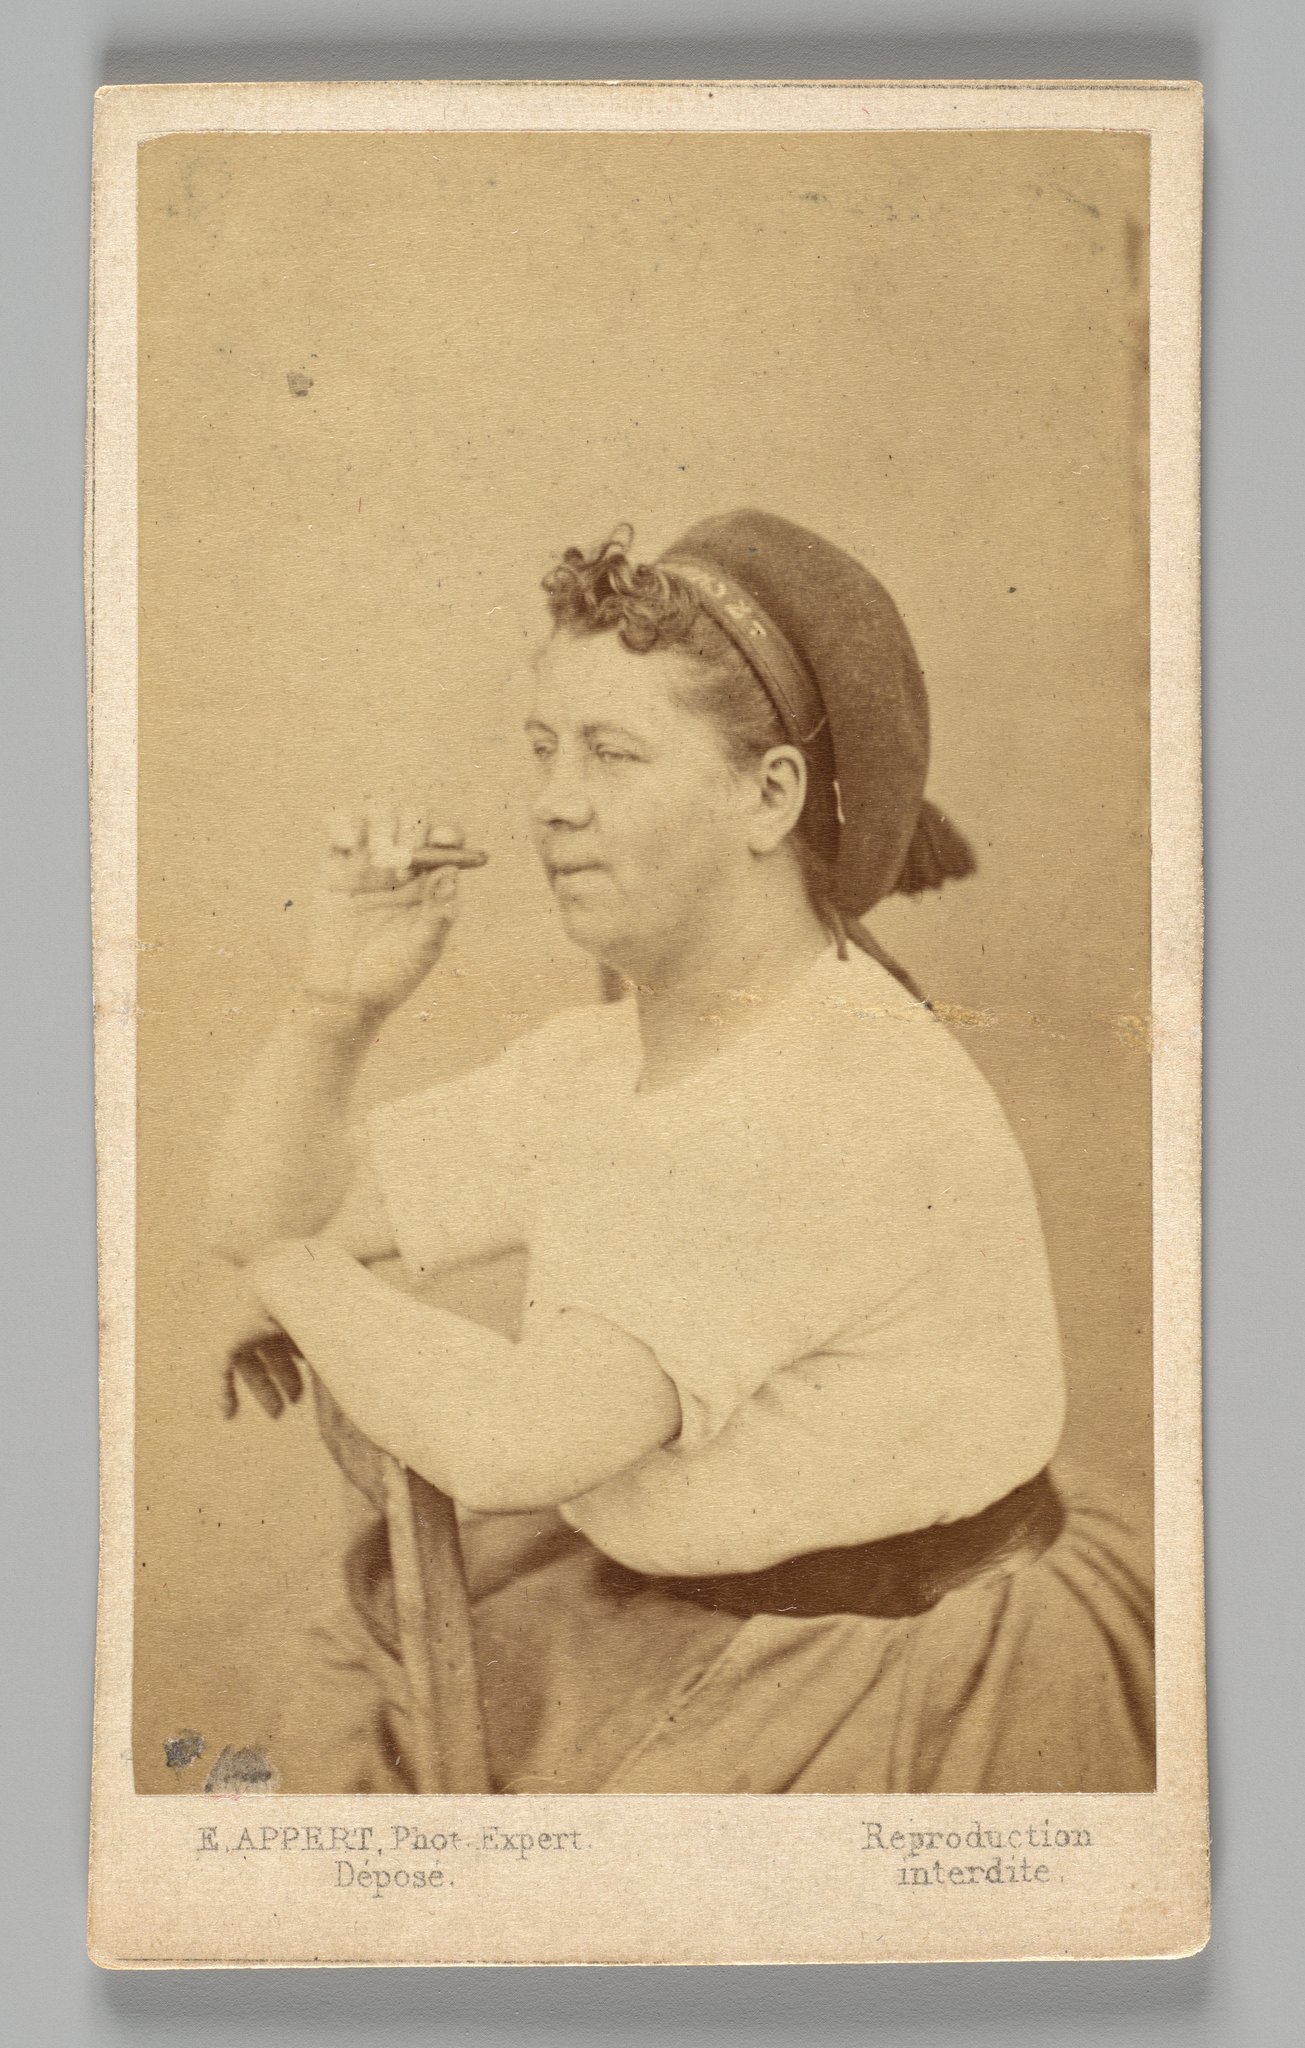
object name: carte de visite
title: [Member of the Paris Commune: Hortense David, pointeuse à la Porte Maillot dans l’artillerie des fédérés, à perpétuité]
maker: ernest eugène appert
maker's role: artist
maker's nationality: french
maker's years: 1831-1891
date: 1871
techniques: albumen silver print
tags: portraits,women